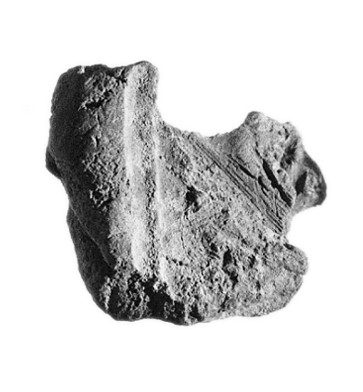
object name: sealing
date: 2030-1640 BCE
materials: clay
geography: egypt